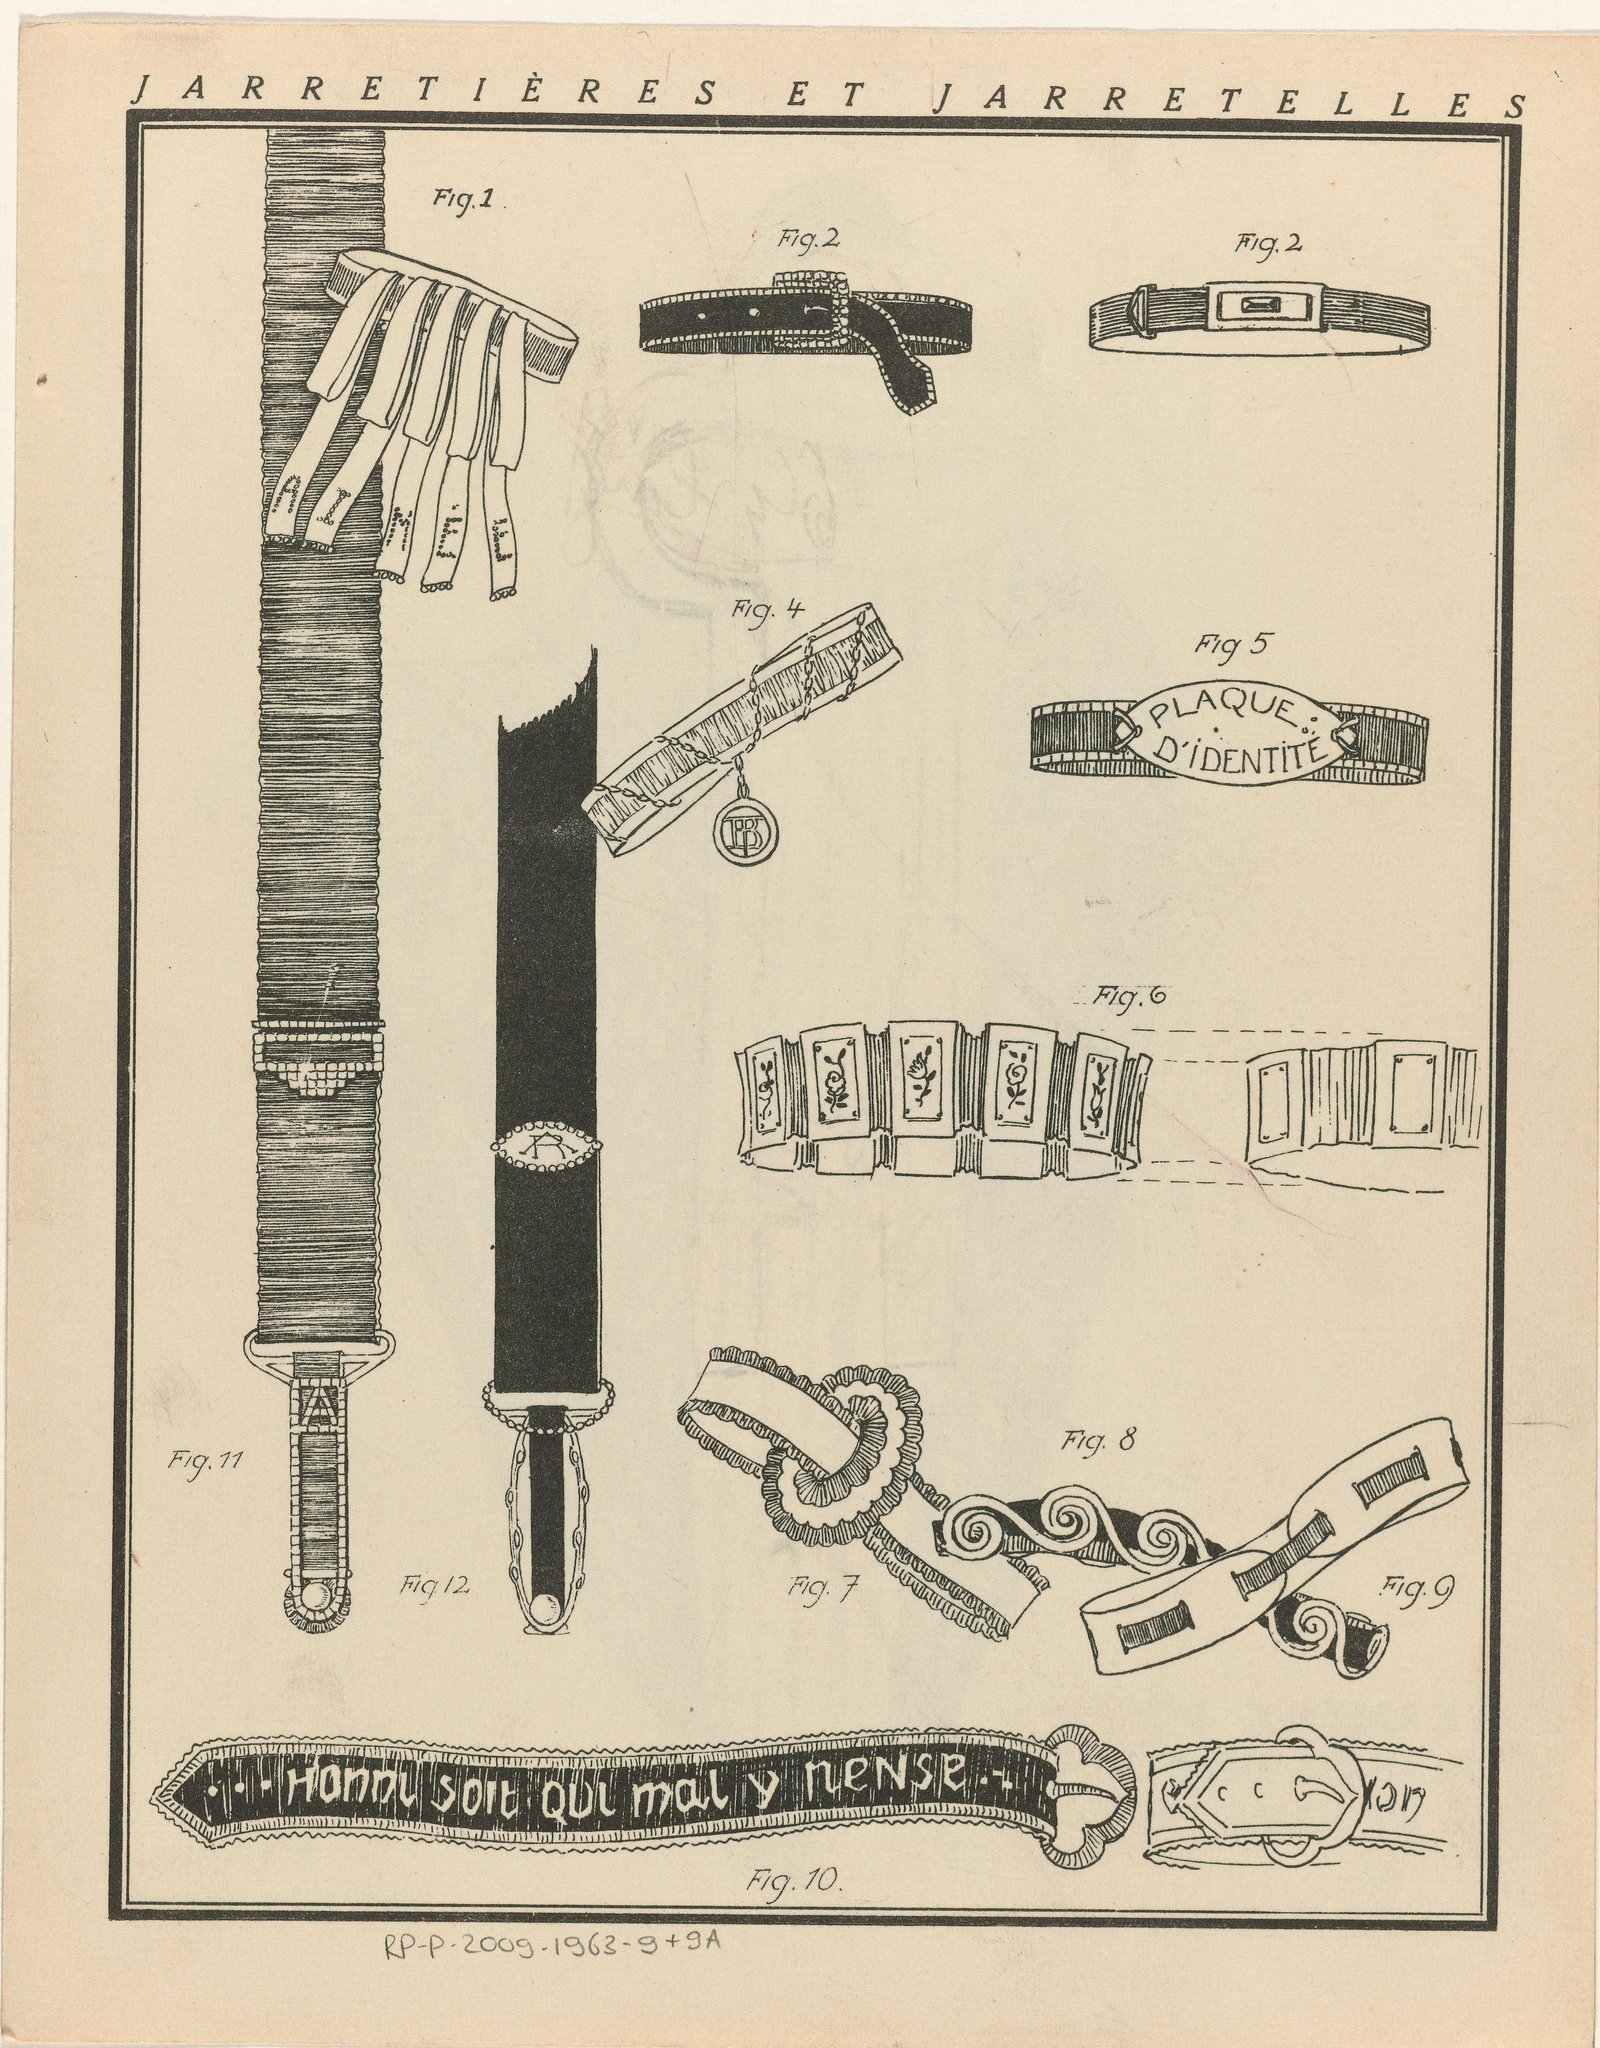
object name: fashion print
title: Gazette du Bon Ton, 1922 - No. 8 : Jarretières et jarretelles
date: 1922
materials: paper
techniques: letterpress printing, lithograph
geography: new york city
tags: braces, suspenders (+ women's clothes), fashion plates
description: Kousenbanden en jarretels. Croquis No I verso uit Gazette du Bon Ton 1922, No. 9. Uitleg over de accessoires op pagina "Description et explication des planches hors-texte et pages de croquis."